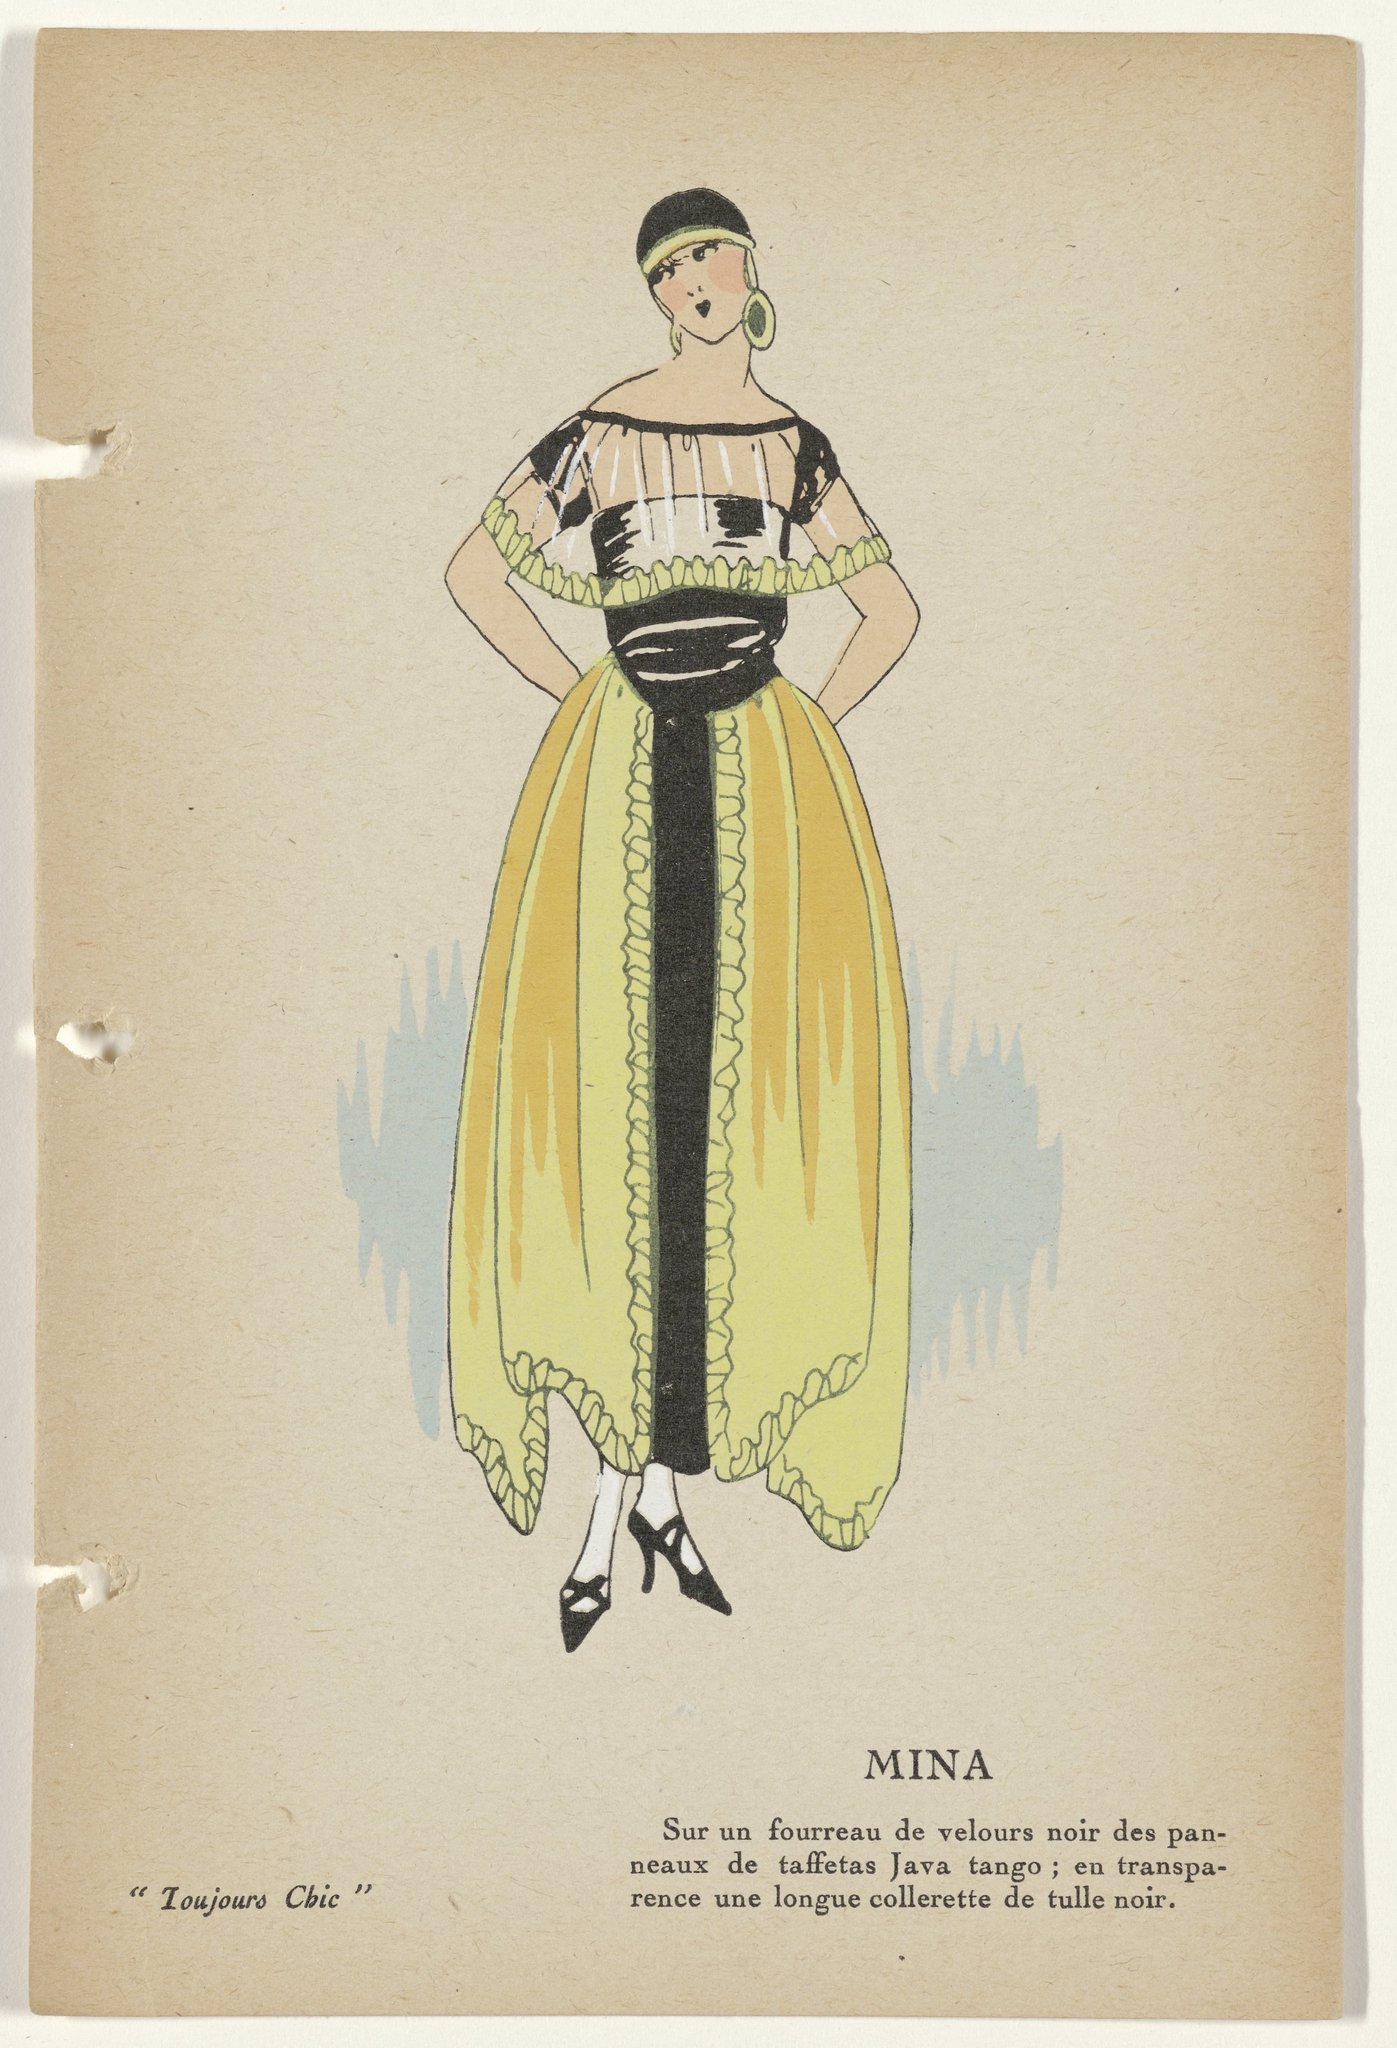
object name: titelprent, frontispice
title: Toujours Chic, Toilettes de Soirées, Hiver 1921-1922: Mina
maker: g-p. joumard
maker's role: publisher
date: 1921-1922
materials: paper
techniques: letterpress printing, pochoir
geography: paris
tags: fashion plates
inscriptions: date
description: Prent uit Catalogus "Toujours Chic" waarin een overzicht van de wintermode 1921-1922 in 80 prentjes in pochoir techniek.